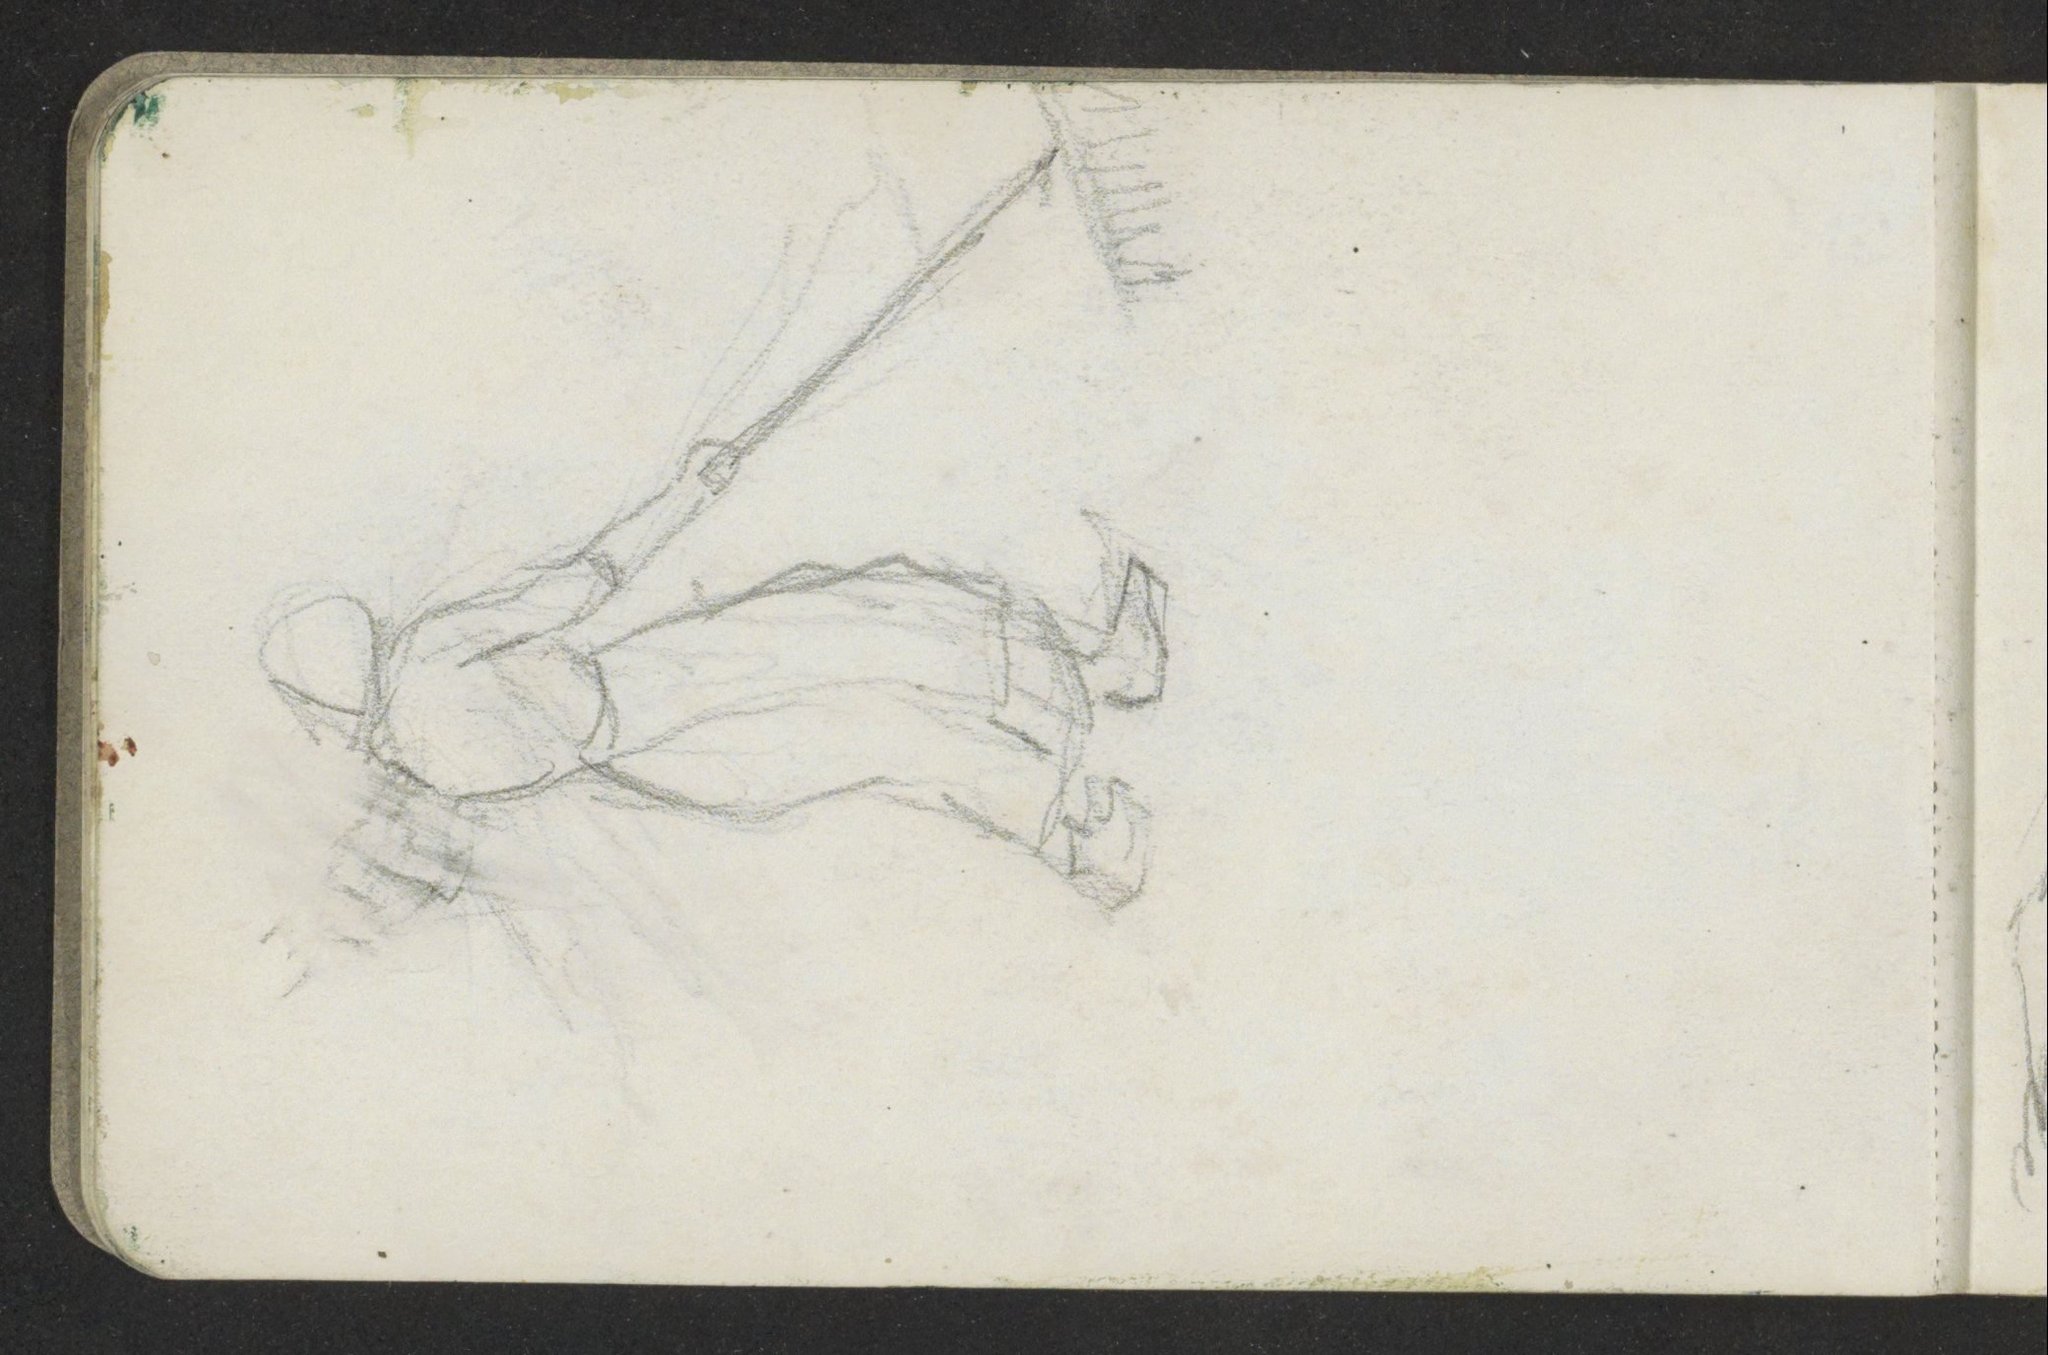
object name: sketchbook leaf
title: Vrouw in een schort met een hark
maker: jozef israëls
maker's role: draughtsman, painter, print maker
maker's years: 1824-1911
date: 1869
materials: paper, pencil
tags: agricultural implements: rake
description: Blad 3 verso uit een schetsboek met 36 bladen.